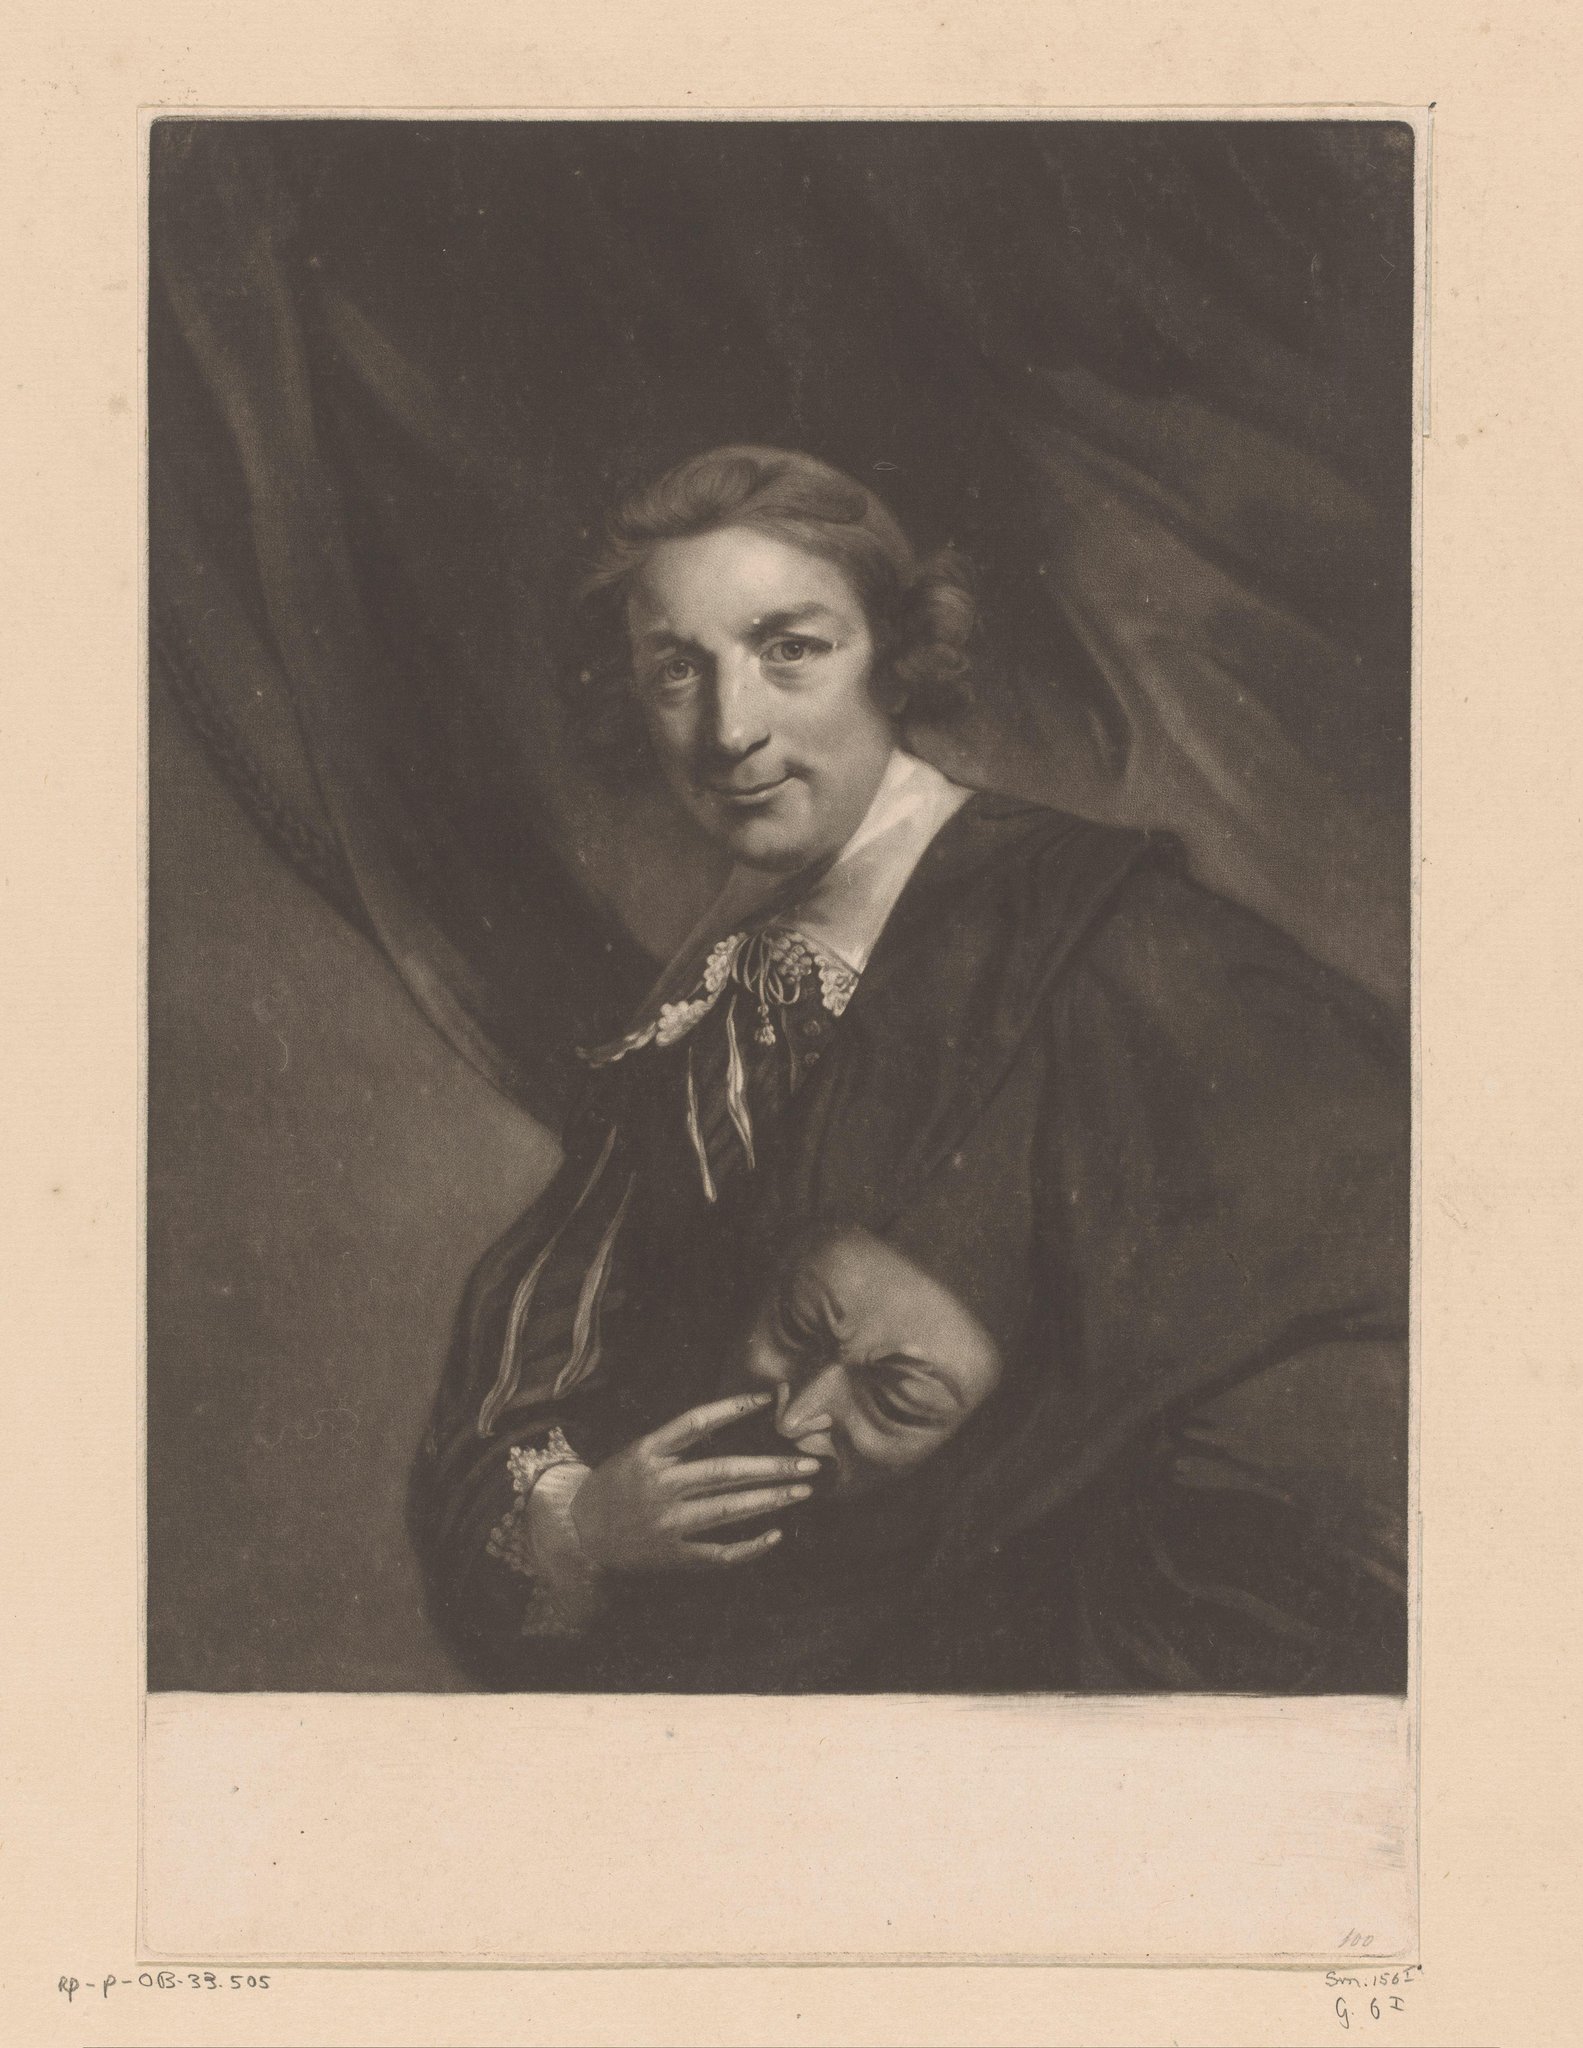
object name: print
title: Portret van Henry Woodward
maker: james watson (prentmaker)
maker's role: print maker, publisher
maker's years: 1740-1790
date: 1765-1771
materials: paper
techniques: mezzotint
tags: mask, historical persons, portrait of actor, actress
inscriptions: number: ‘No 26/ [...]’, collector's mark: Lugt 240